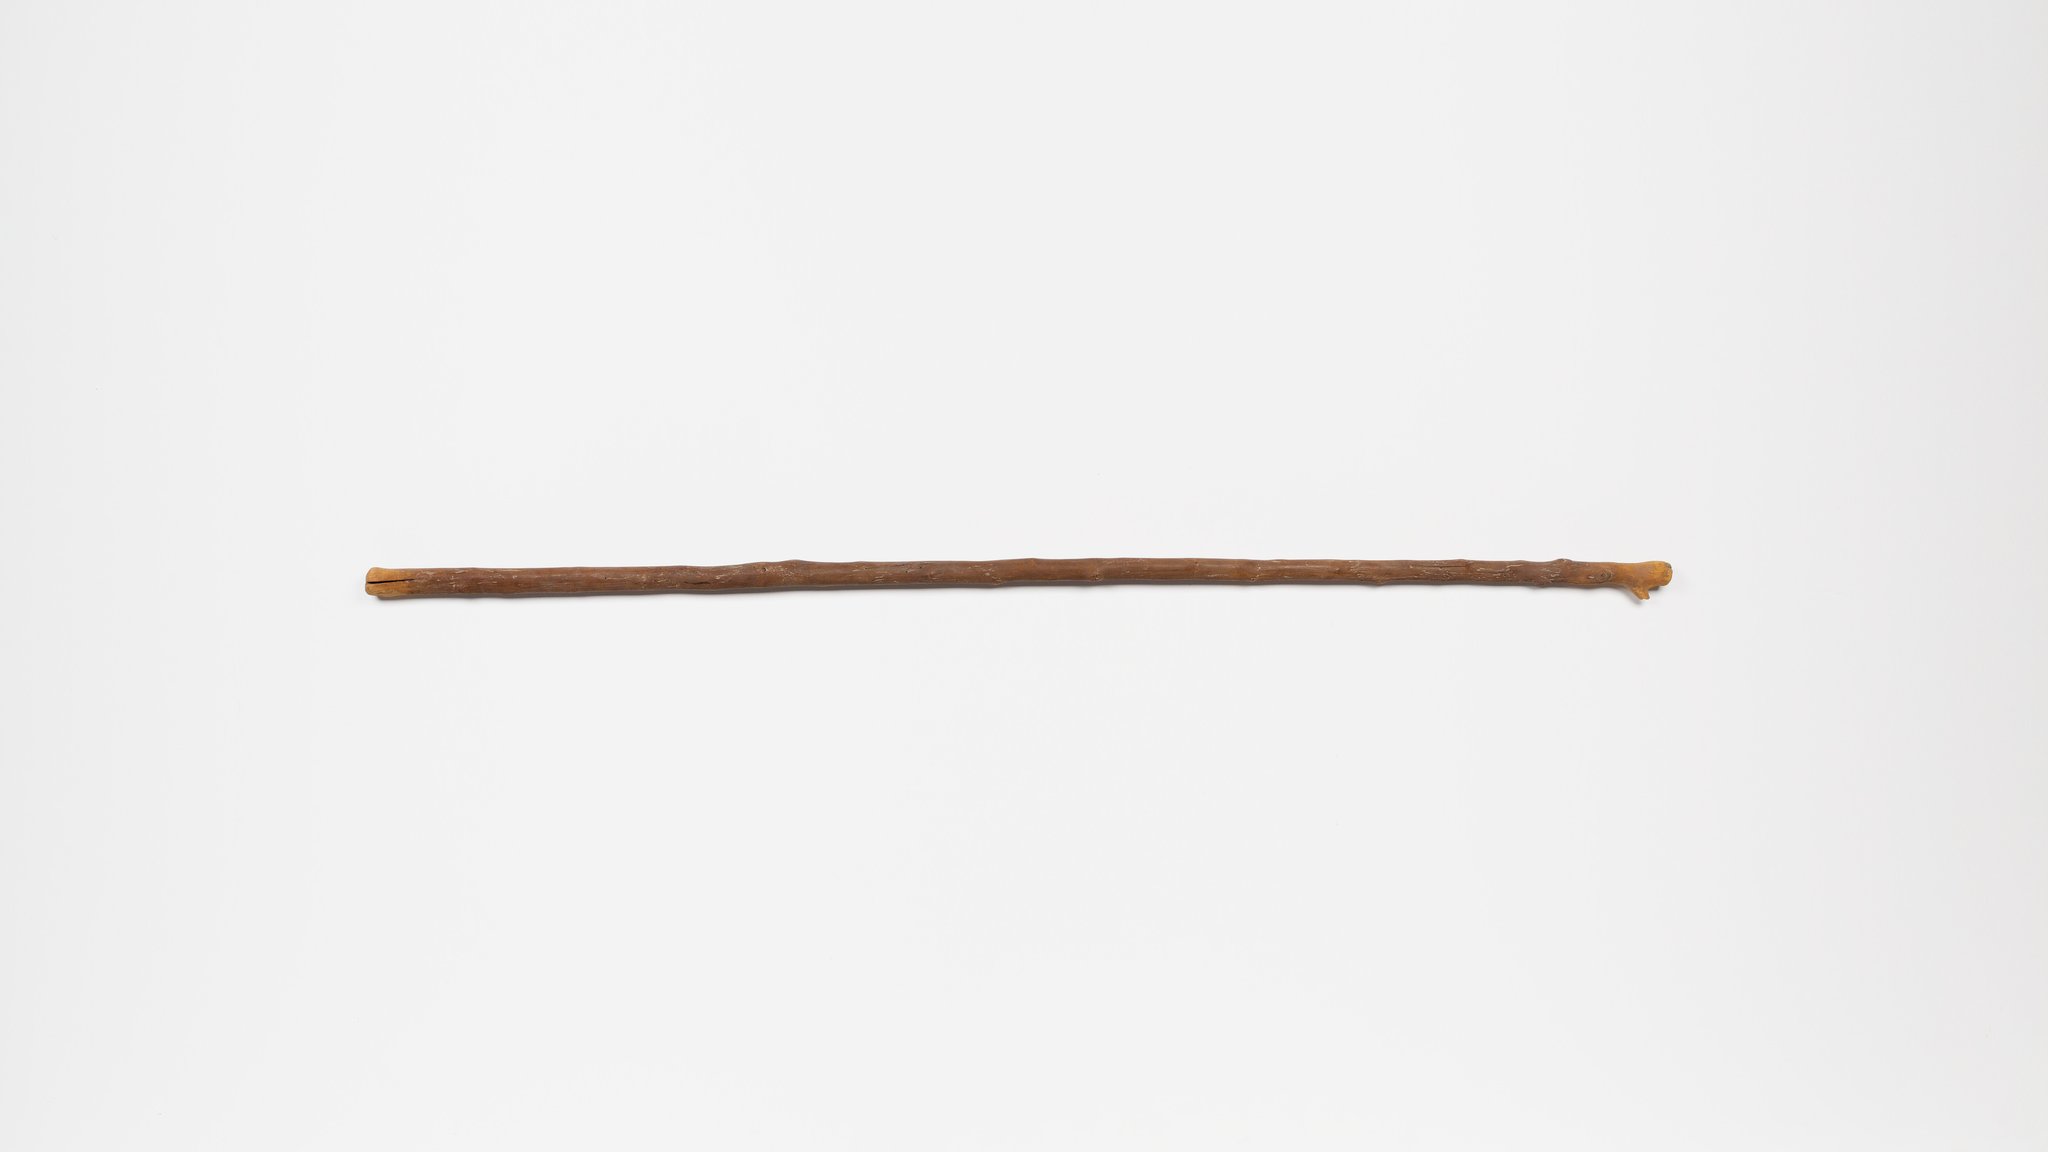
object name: staff, forked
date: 1550-1295 BCE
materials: wood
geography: egypt